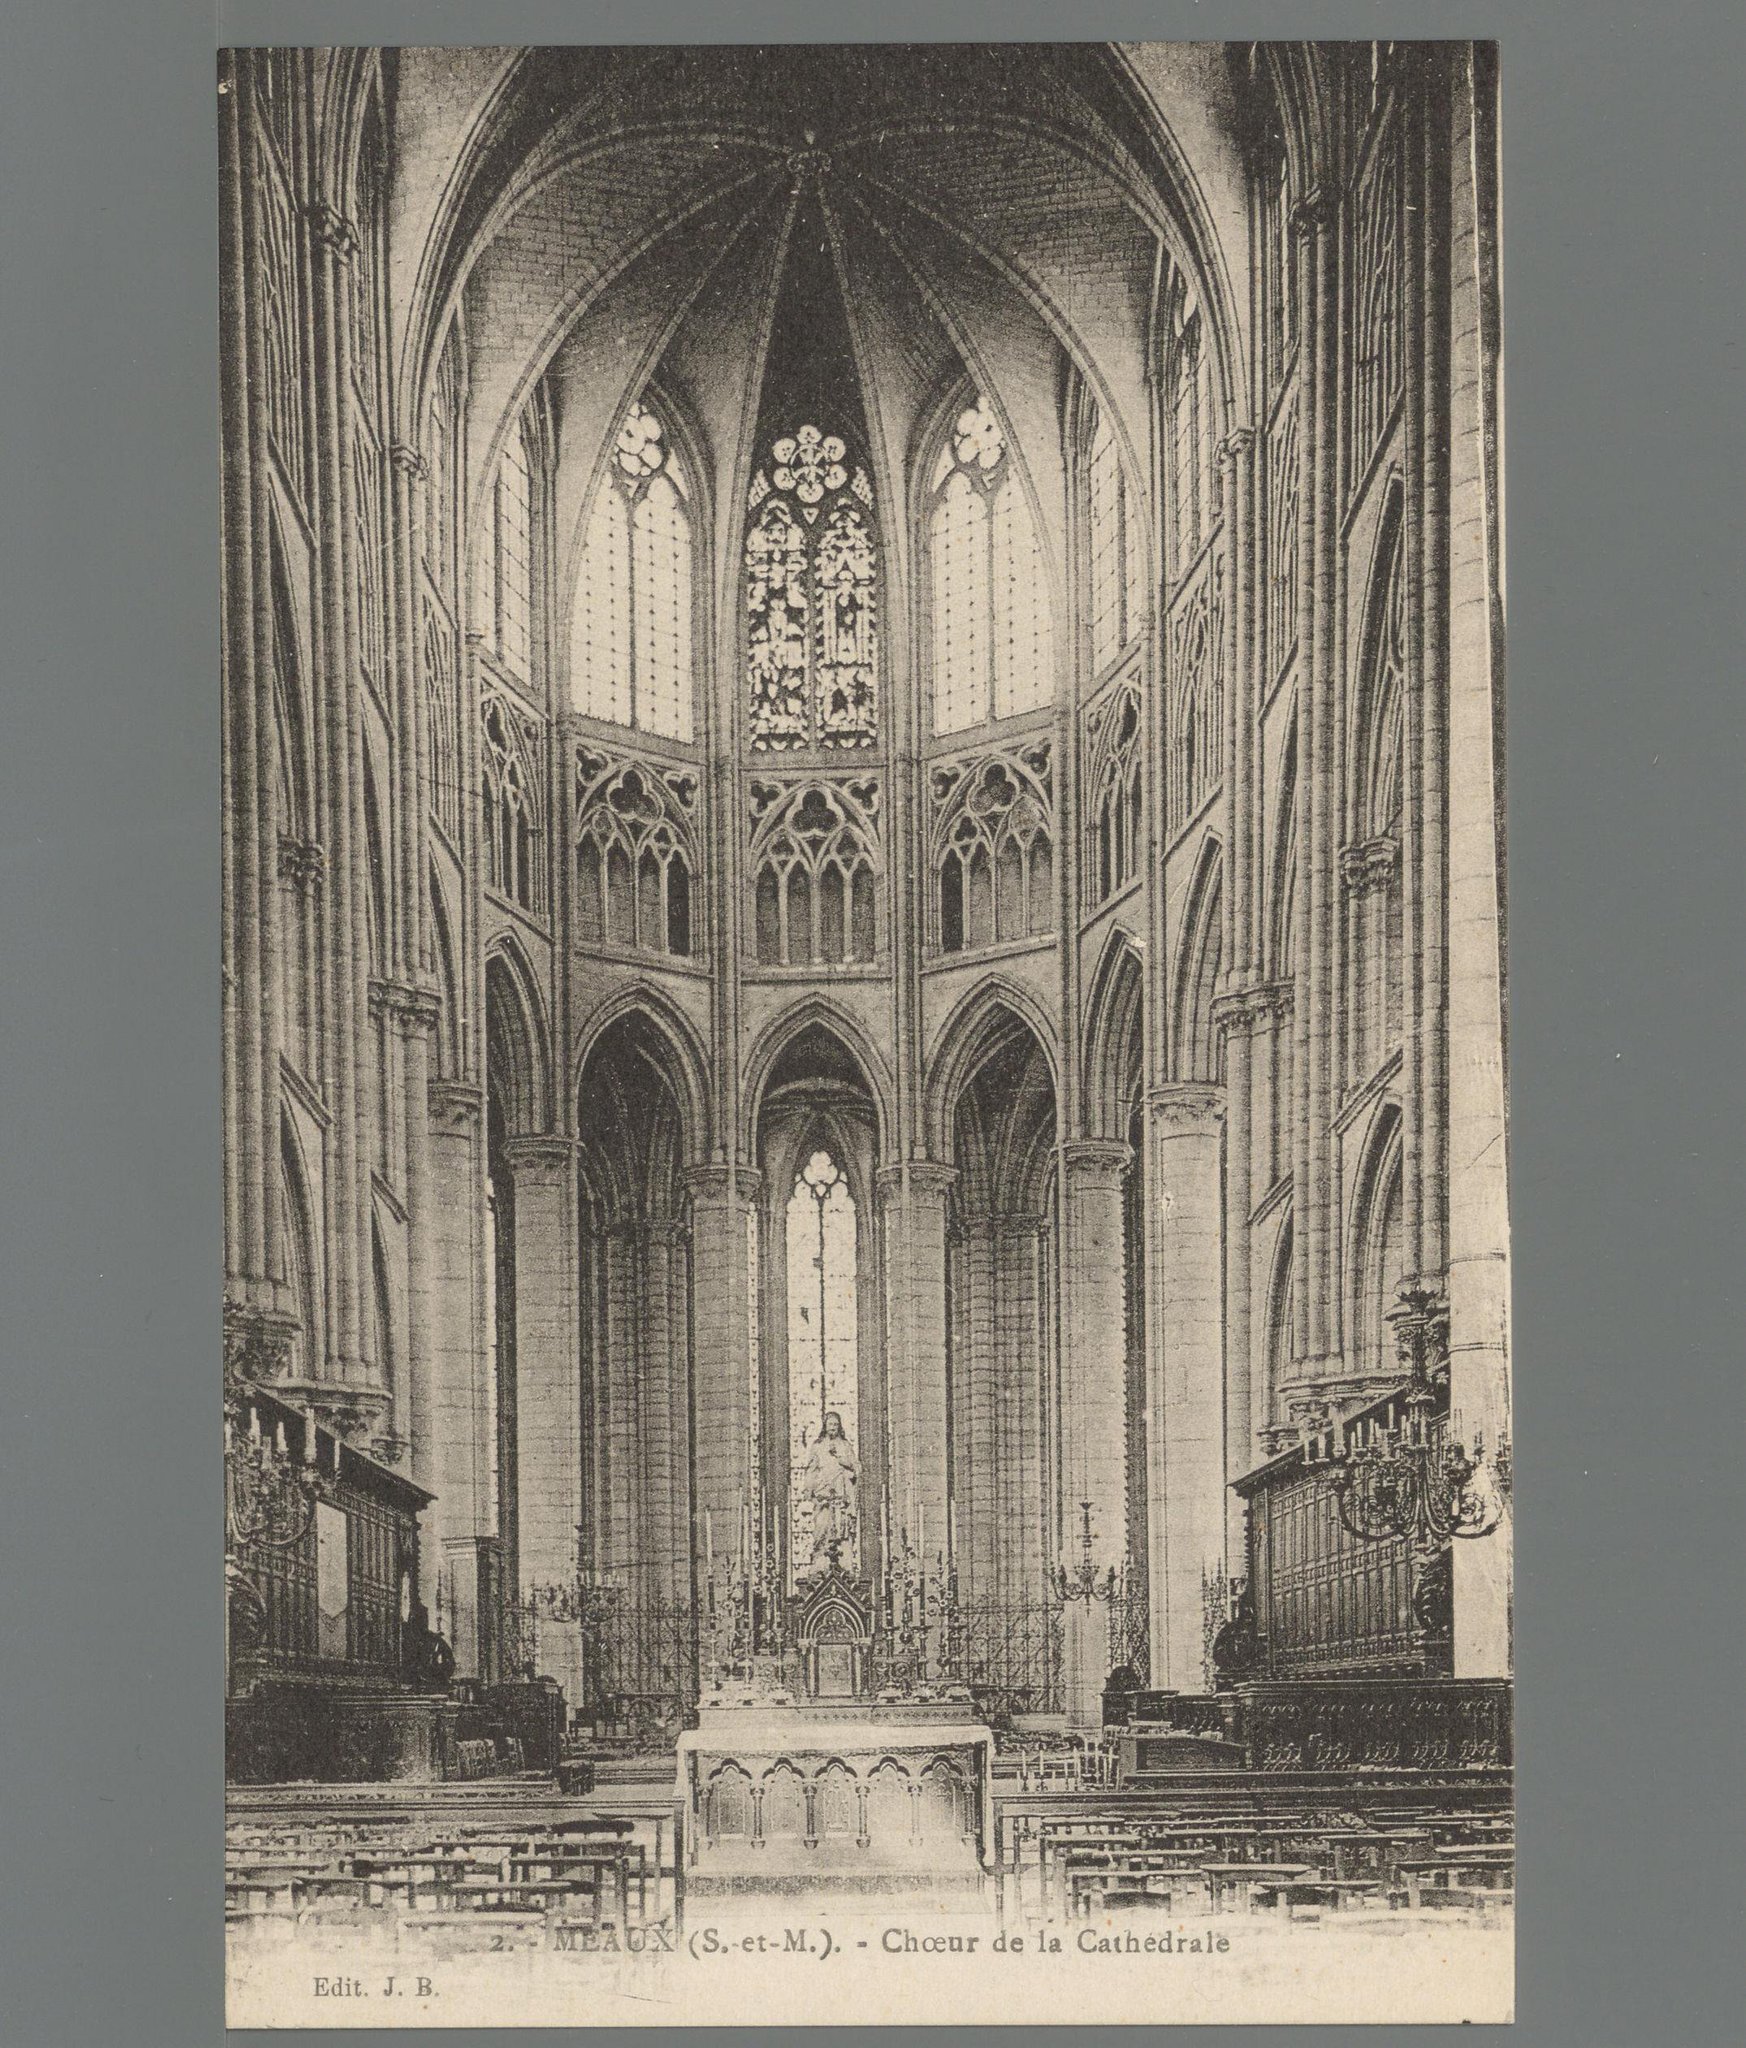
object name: ansichtkaart, prentbriefkaart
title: Meaux (S.-et-M.) - Choeur de la Cathédrale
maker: Anonymous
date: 1903-1930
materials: cardboard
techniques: photograph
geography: château-thierry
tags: interior of church, parts of church interior: choir